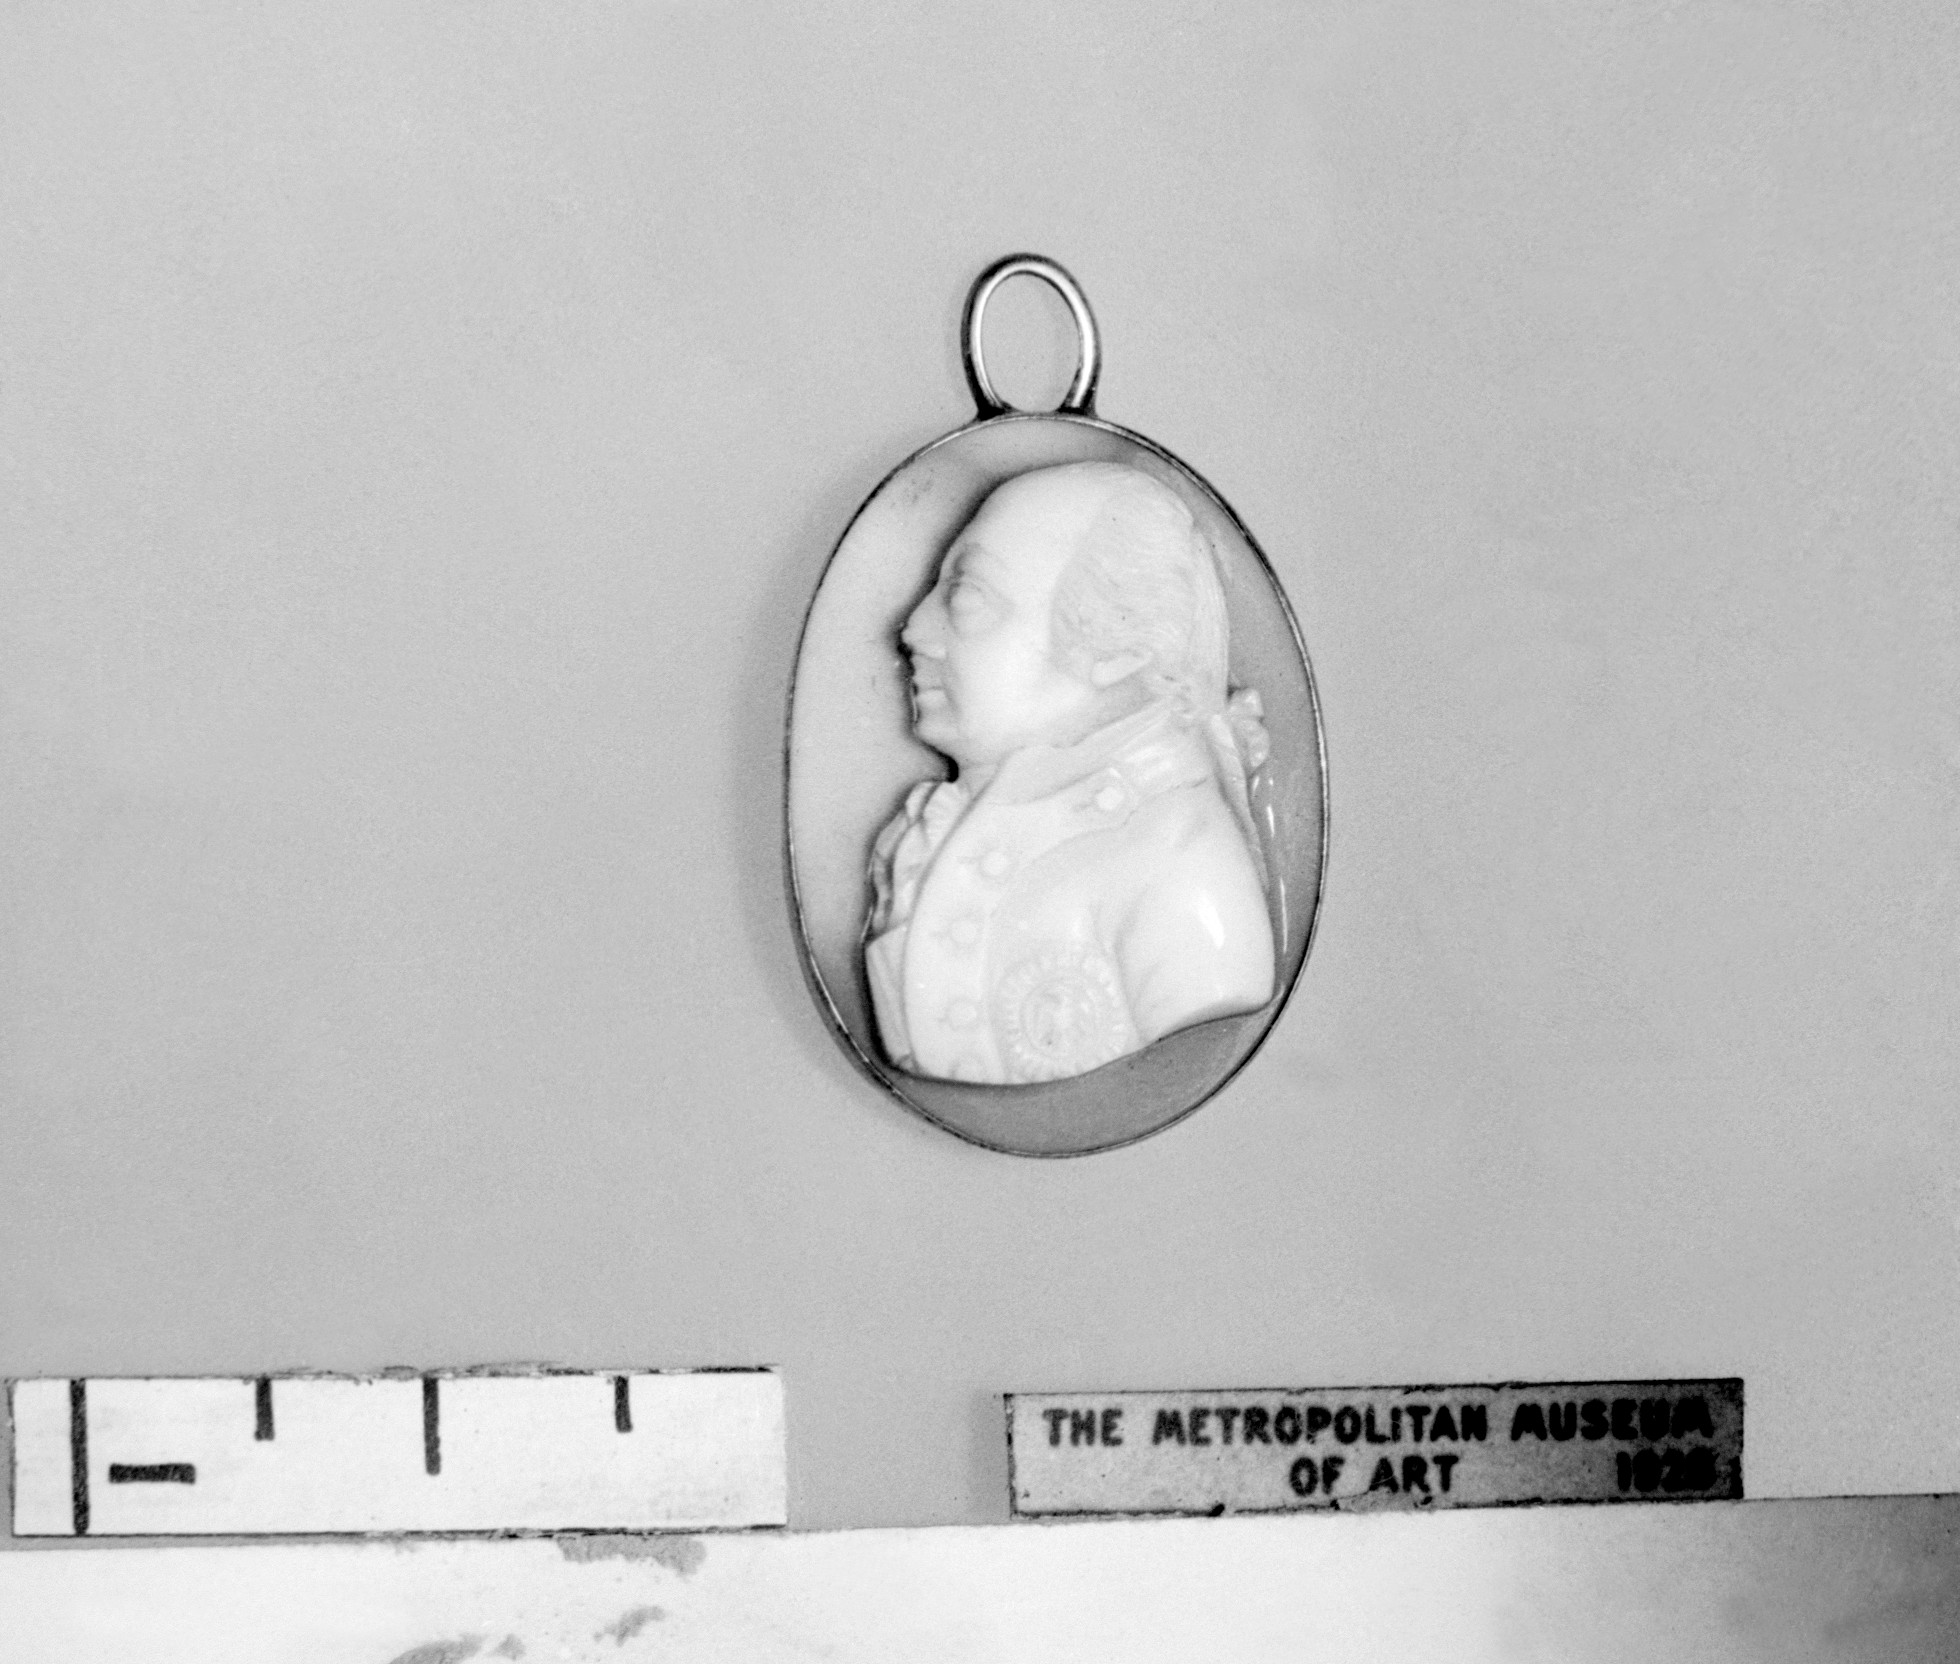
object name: cameo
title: Unidentified male portrait, possibly Frederick of Prussia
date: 1800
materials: gold, onyx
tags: men,profiles